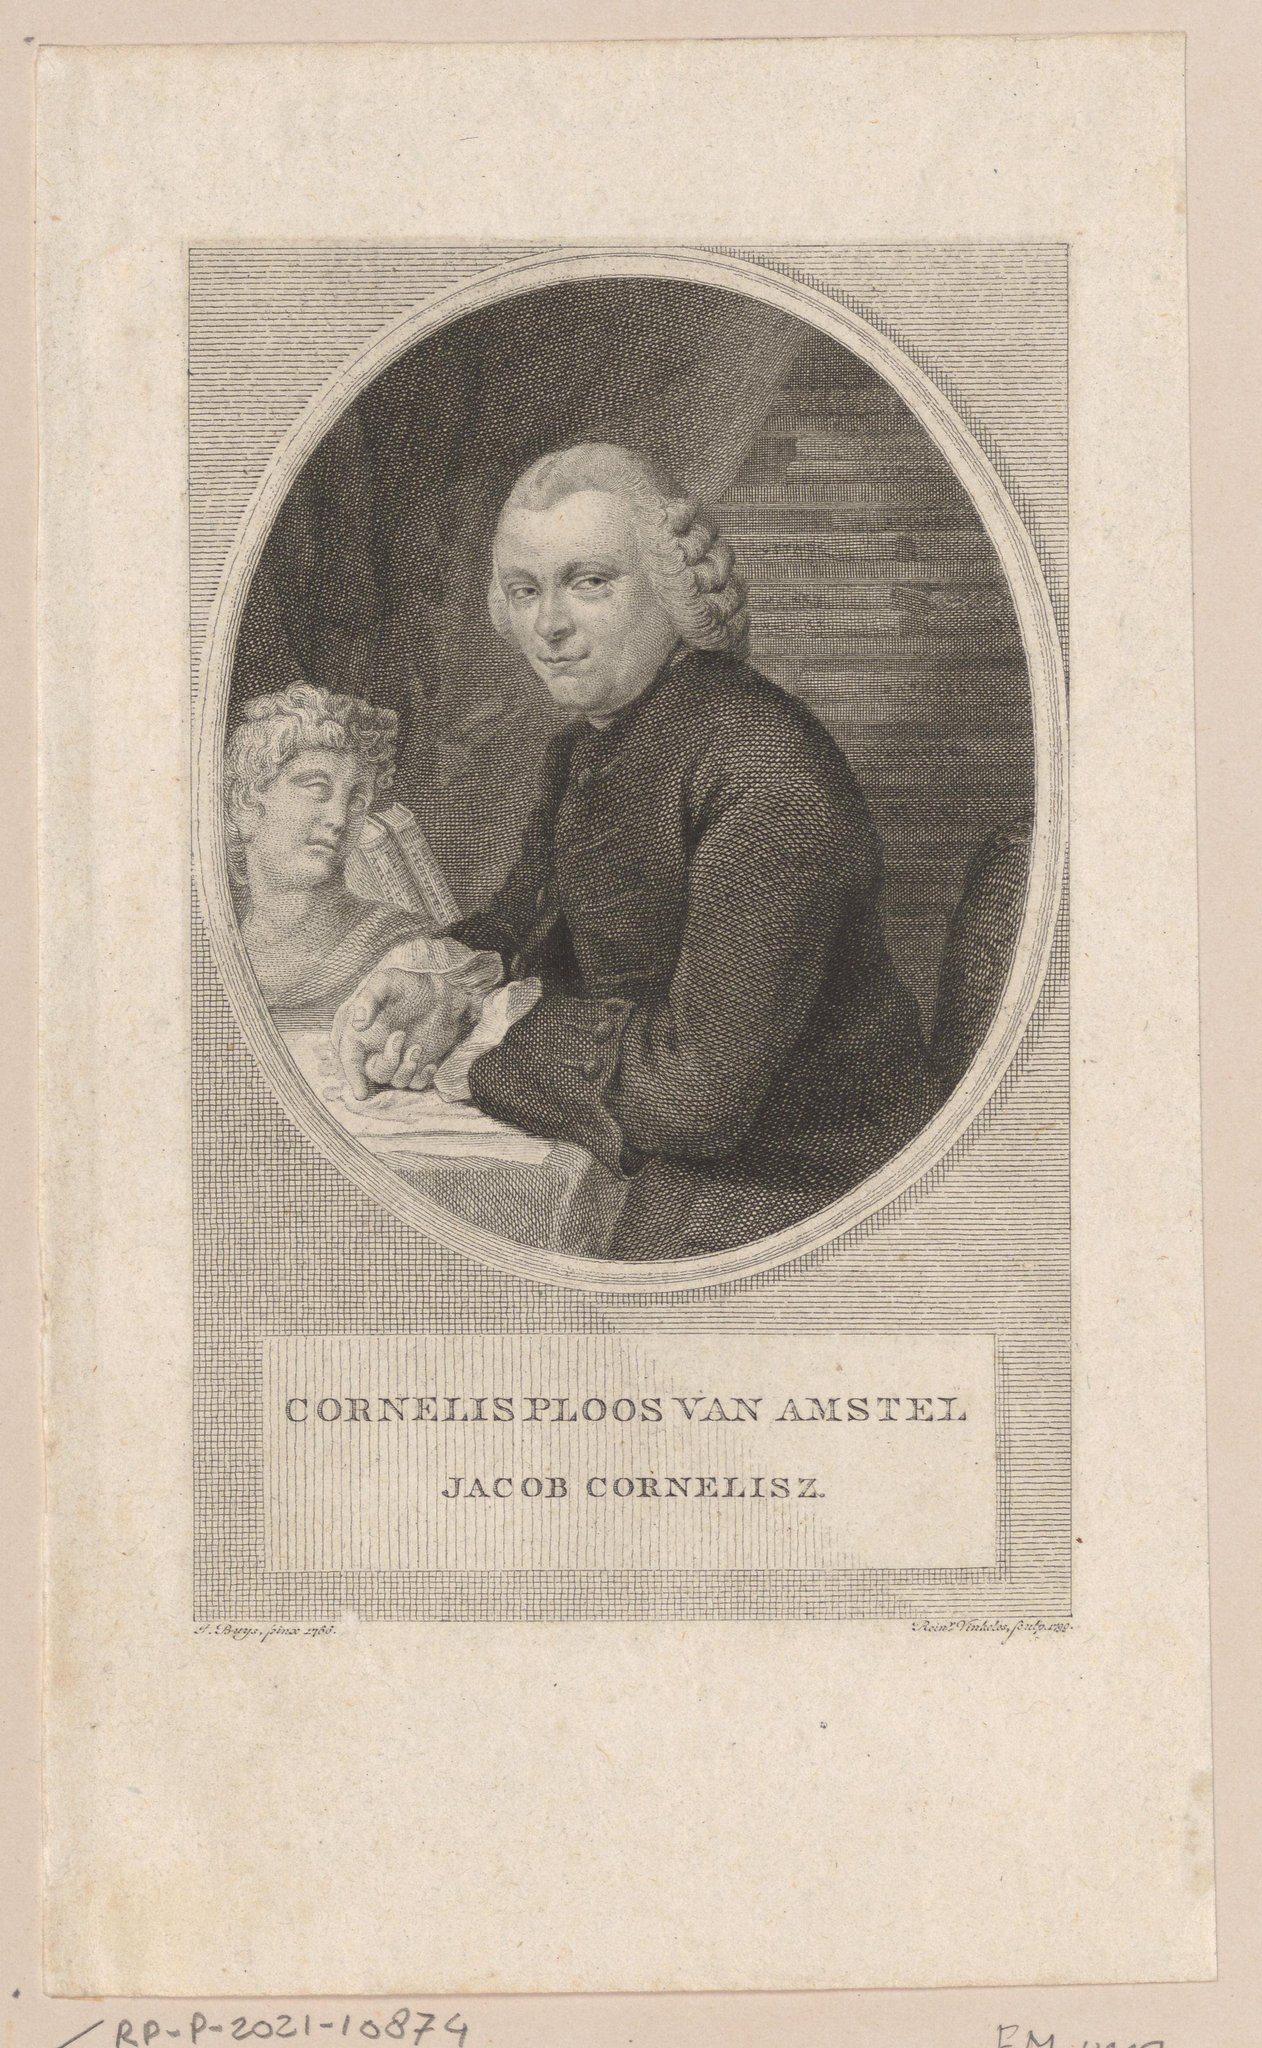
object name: print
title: Portret van Cornelis Ploos van Amstel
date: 1799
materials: paper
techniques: engraving, etching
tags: amsterdam, print maker, cornelis ploos van amstel, drawing, sketch, historical persons, art collector, book, piece of sculpture, reproduction of a piece of sculpture, portrait, self-portrait of graphic artist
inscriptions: collector's mark: Lugt 964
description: Portret van de prentmaker en tekenaar Cornelis Ploos van Amstel, zittend aan een tafel met daarop een gebeeldhouwde buste. Zijn hand wijst op een tekening.